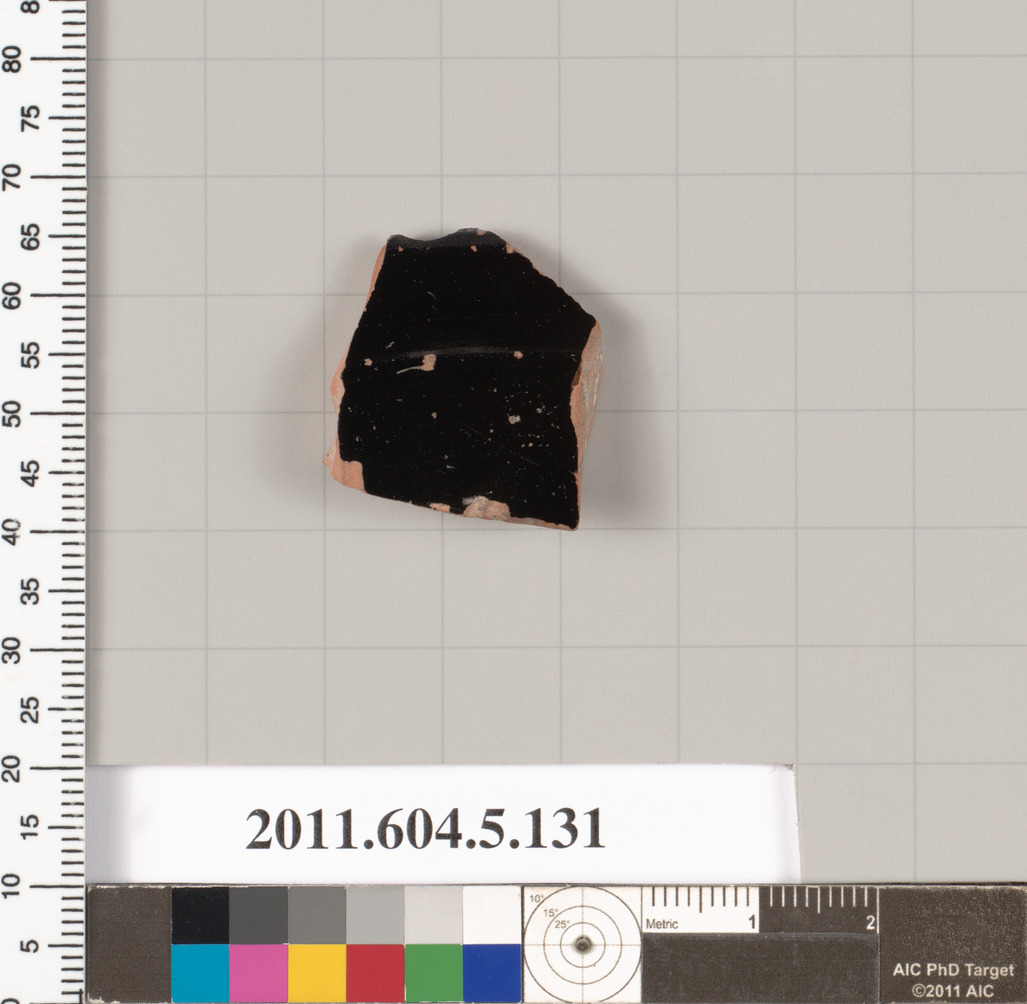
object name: kylix fragment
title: Terracotta fragment of a stemless kylix (drinking cup)?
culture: greek, attic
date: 470-450 BCE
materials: terracotta